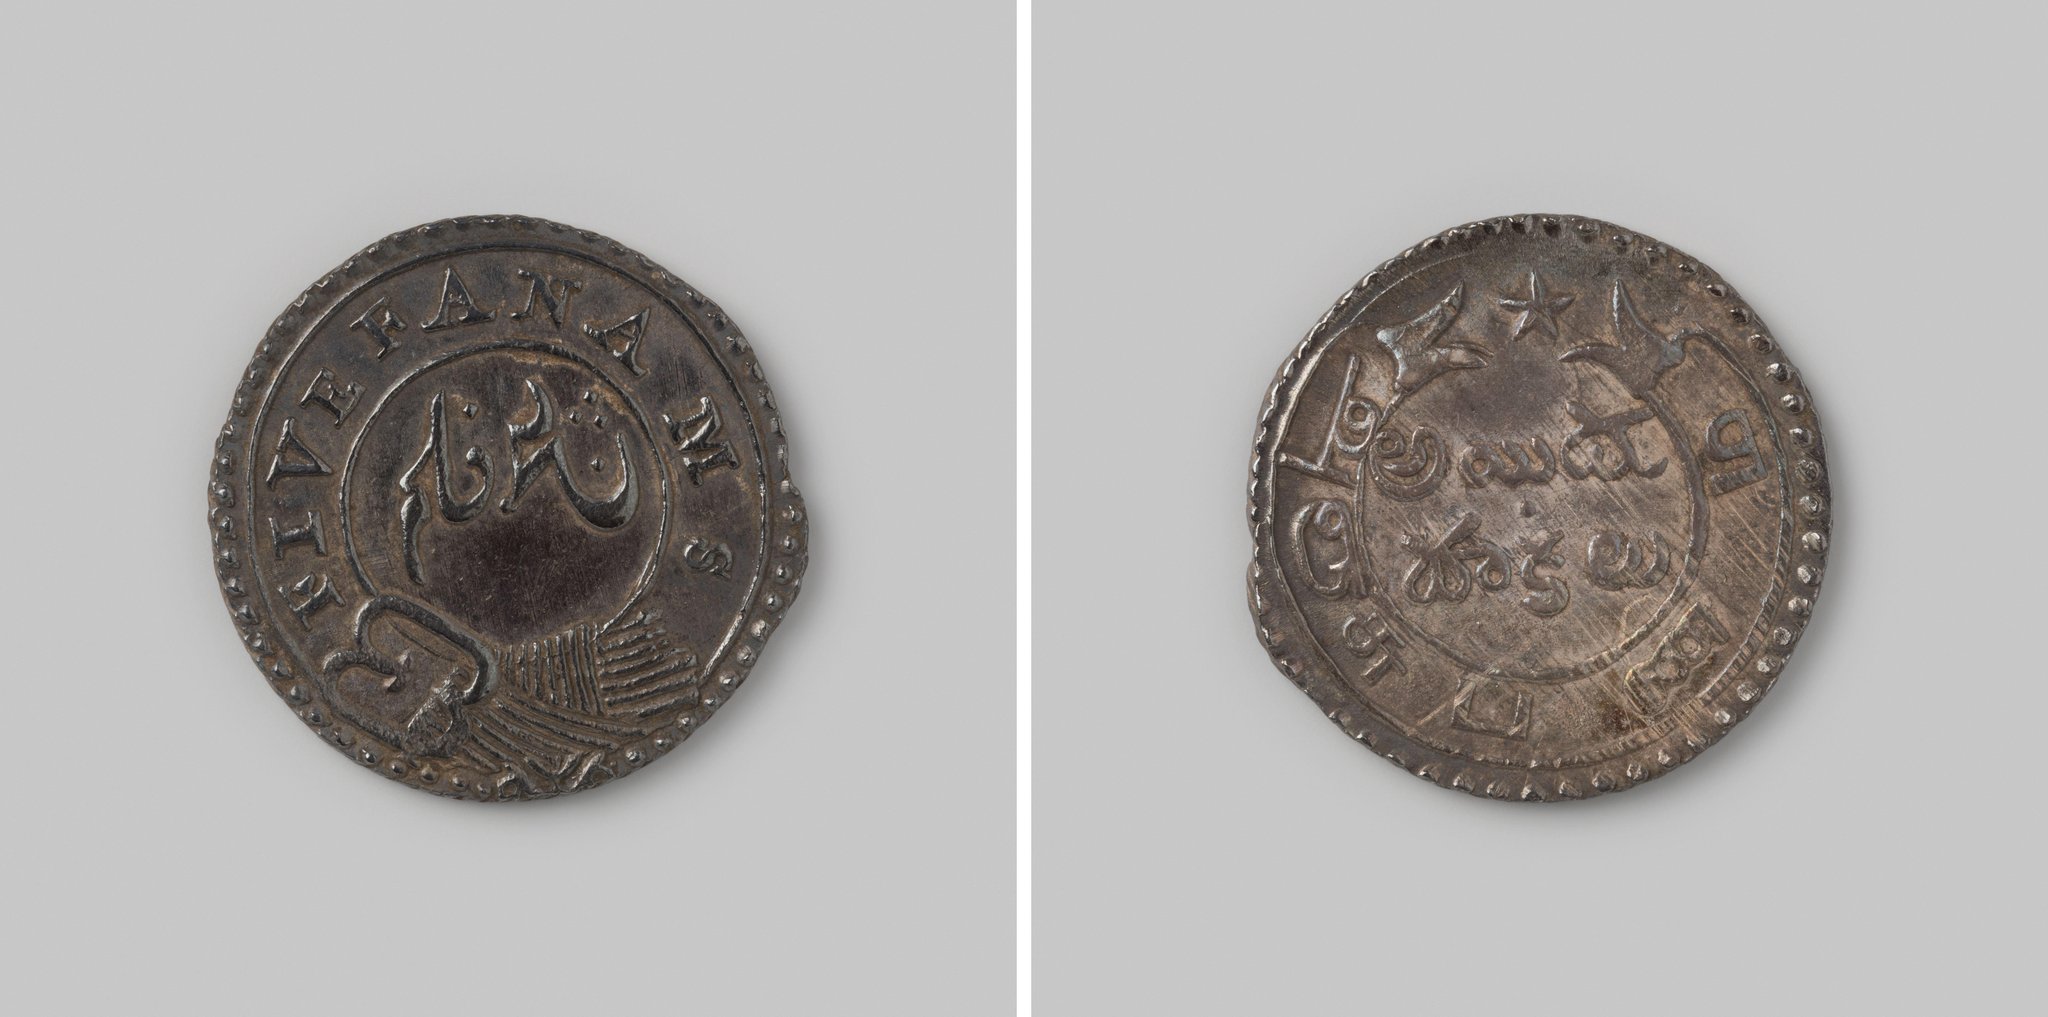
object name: coin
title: Madras, India, Engelse Oostindische Compagnie (EIC), 5 fanams, (1808)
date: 1808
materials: silver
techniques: striking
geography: chennai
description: Zilveren munt. Voorzijde: binnen cirkel, gevormd door ceintuur met gesp, waarde-aanduiding in het Engels: five fanams, op een regel waarde-aanduiding in Arabische lettertekens. Keerzijde: binnen cirkel, gevormd door lint, waarop waarde-aanduiding in het Tamil, in twee regels waarde-aanduiding in het Telugu. Bovenaan, tussen uiteinden van het lint, een ster. Kabelrand.